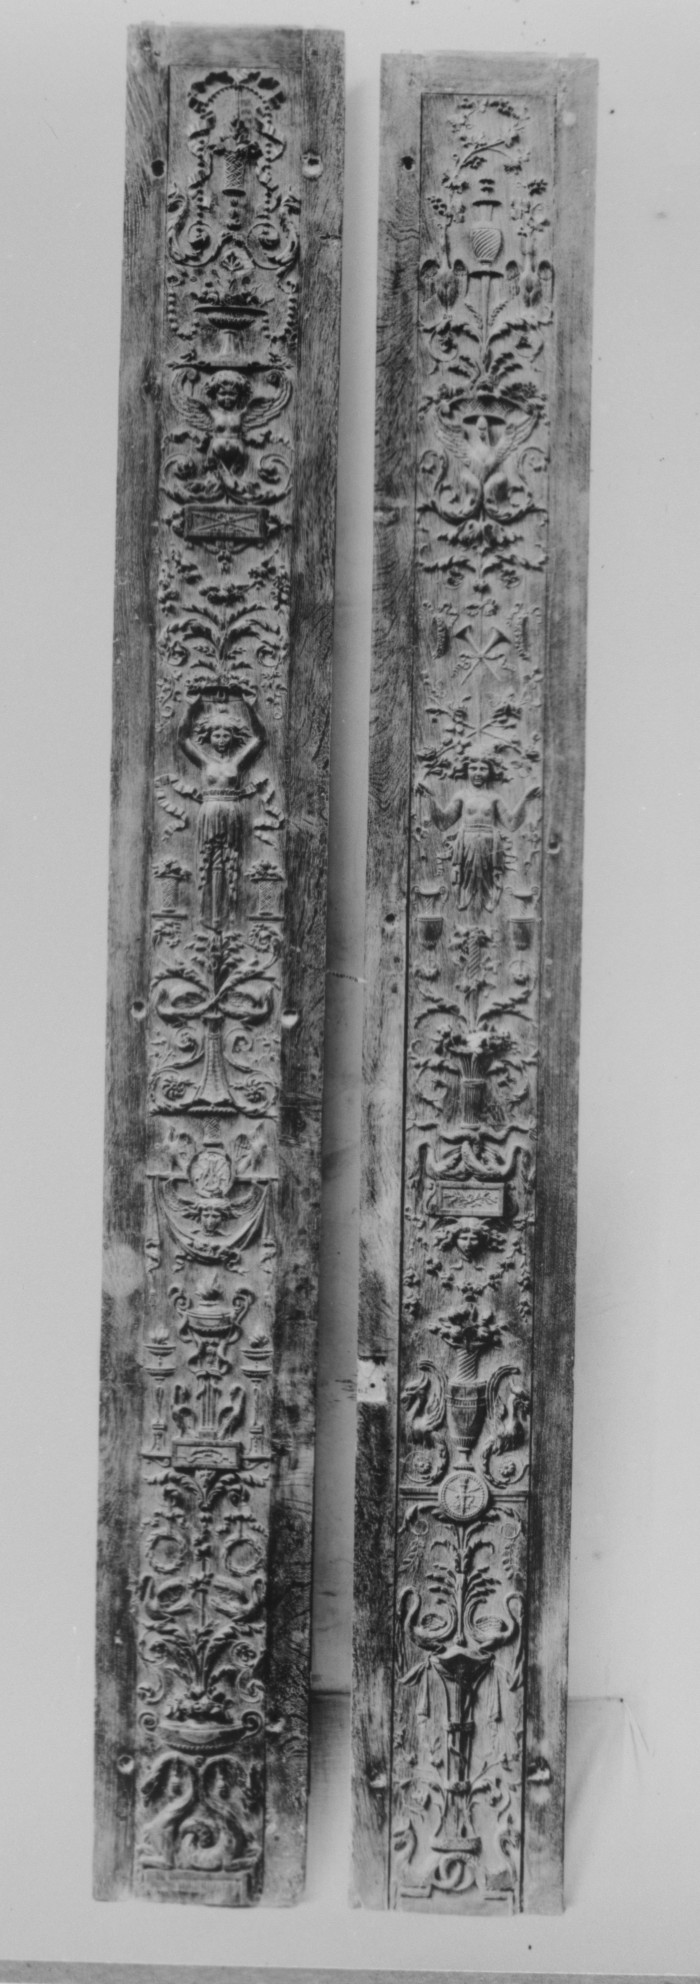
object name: pilaster panel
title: Pilaster panel (part of a set of eight)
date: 1701-1800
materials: wood